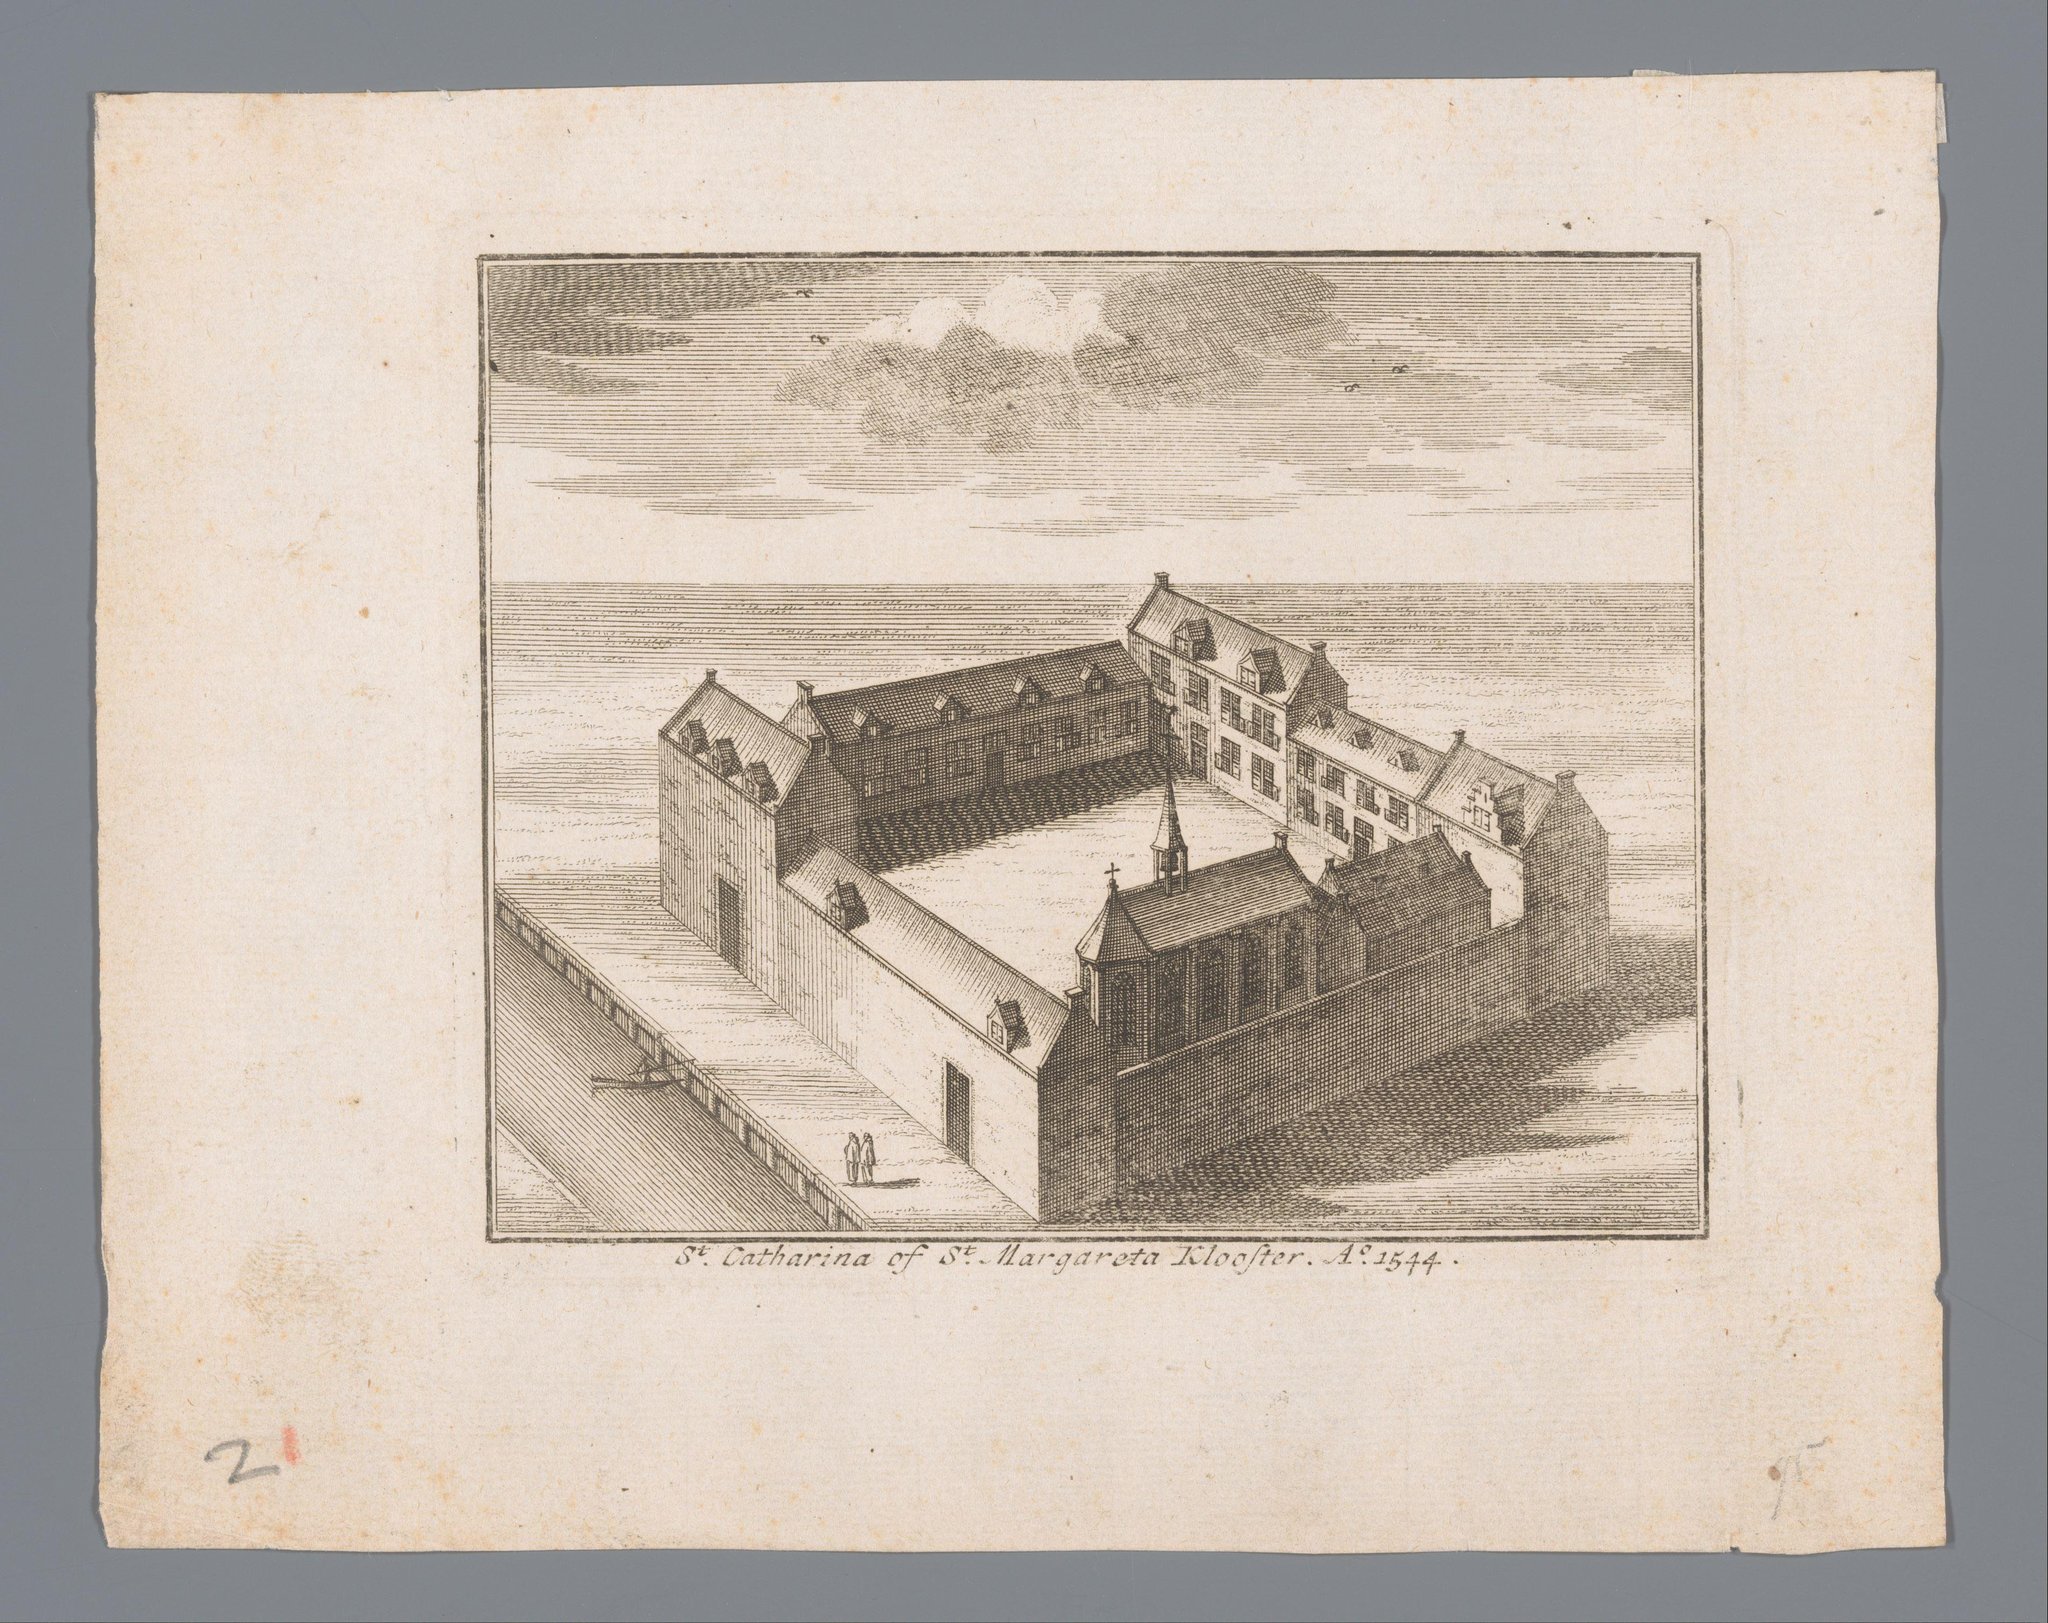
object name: print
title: St. Catharina of St. Margareta Klooster. Ao. 1544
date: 1729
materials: paper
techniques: etching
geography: amsterdam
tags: abbey, monastery, convent ~ roman catholic church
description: Prent verschenen in: Long, Isaak Le. Historische beschryvinge van de Reformatie der stadt Amsterdam. Amsterdam: Johannes van Septeren, 1729.